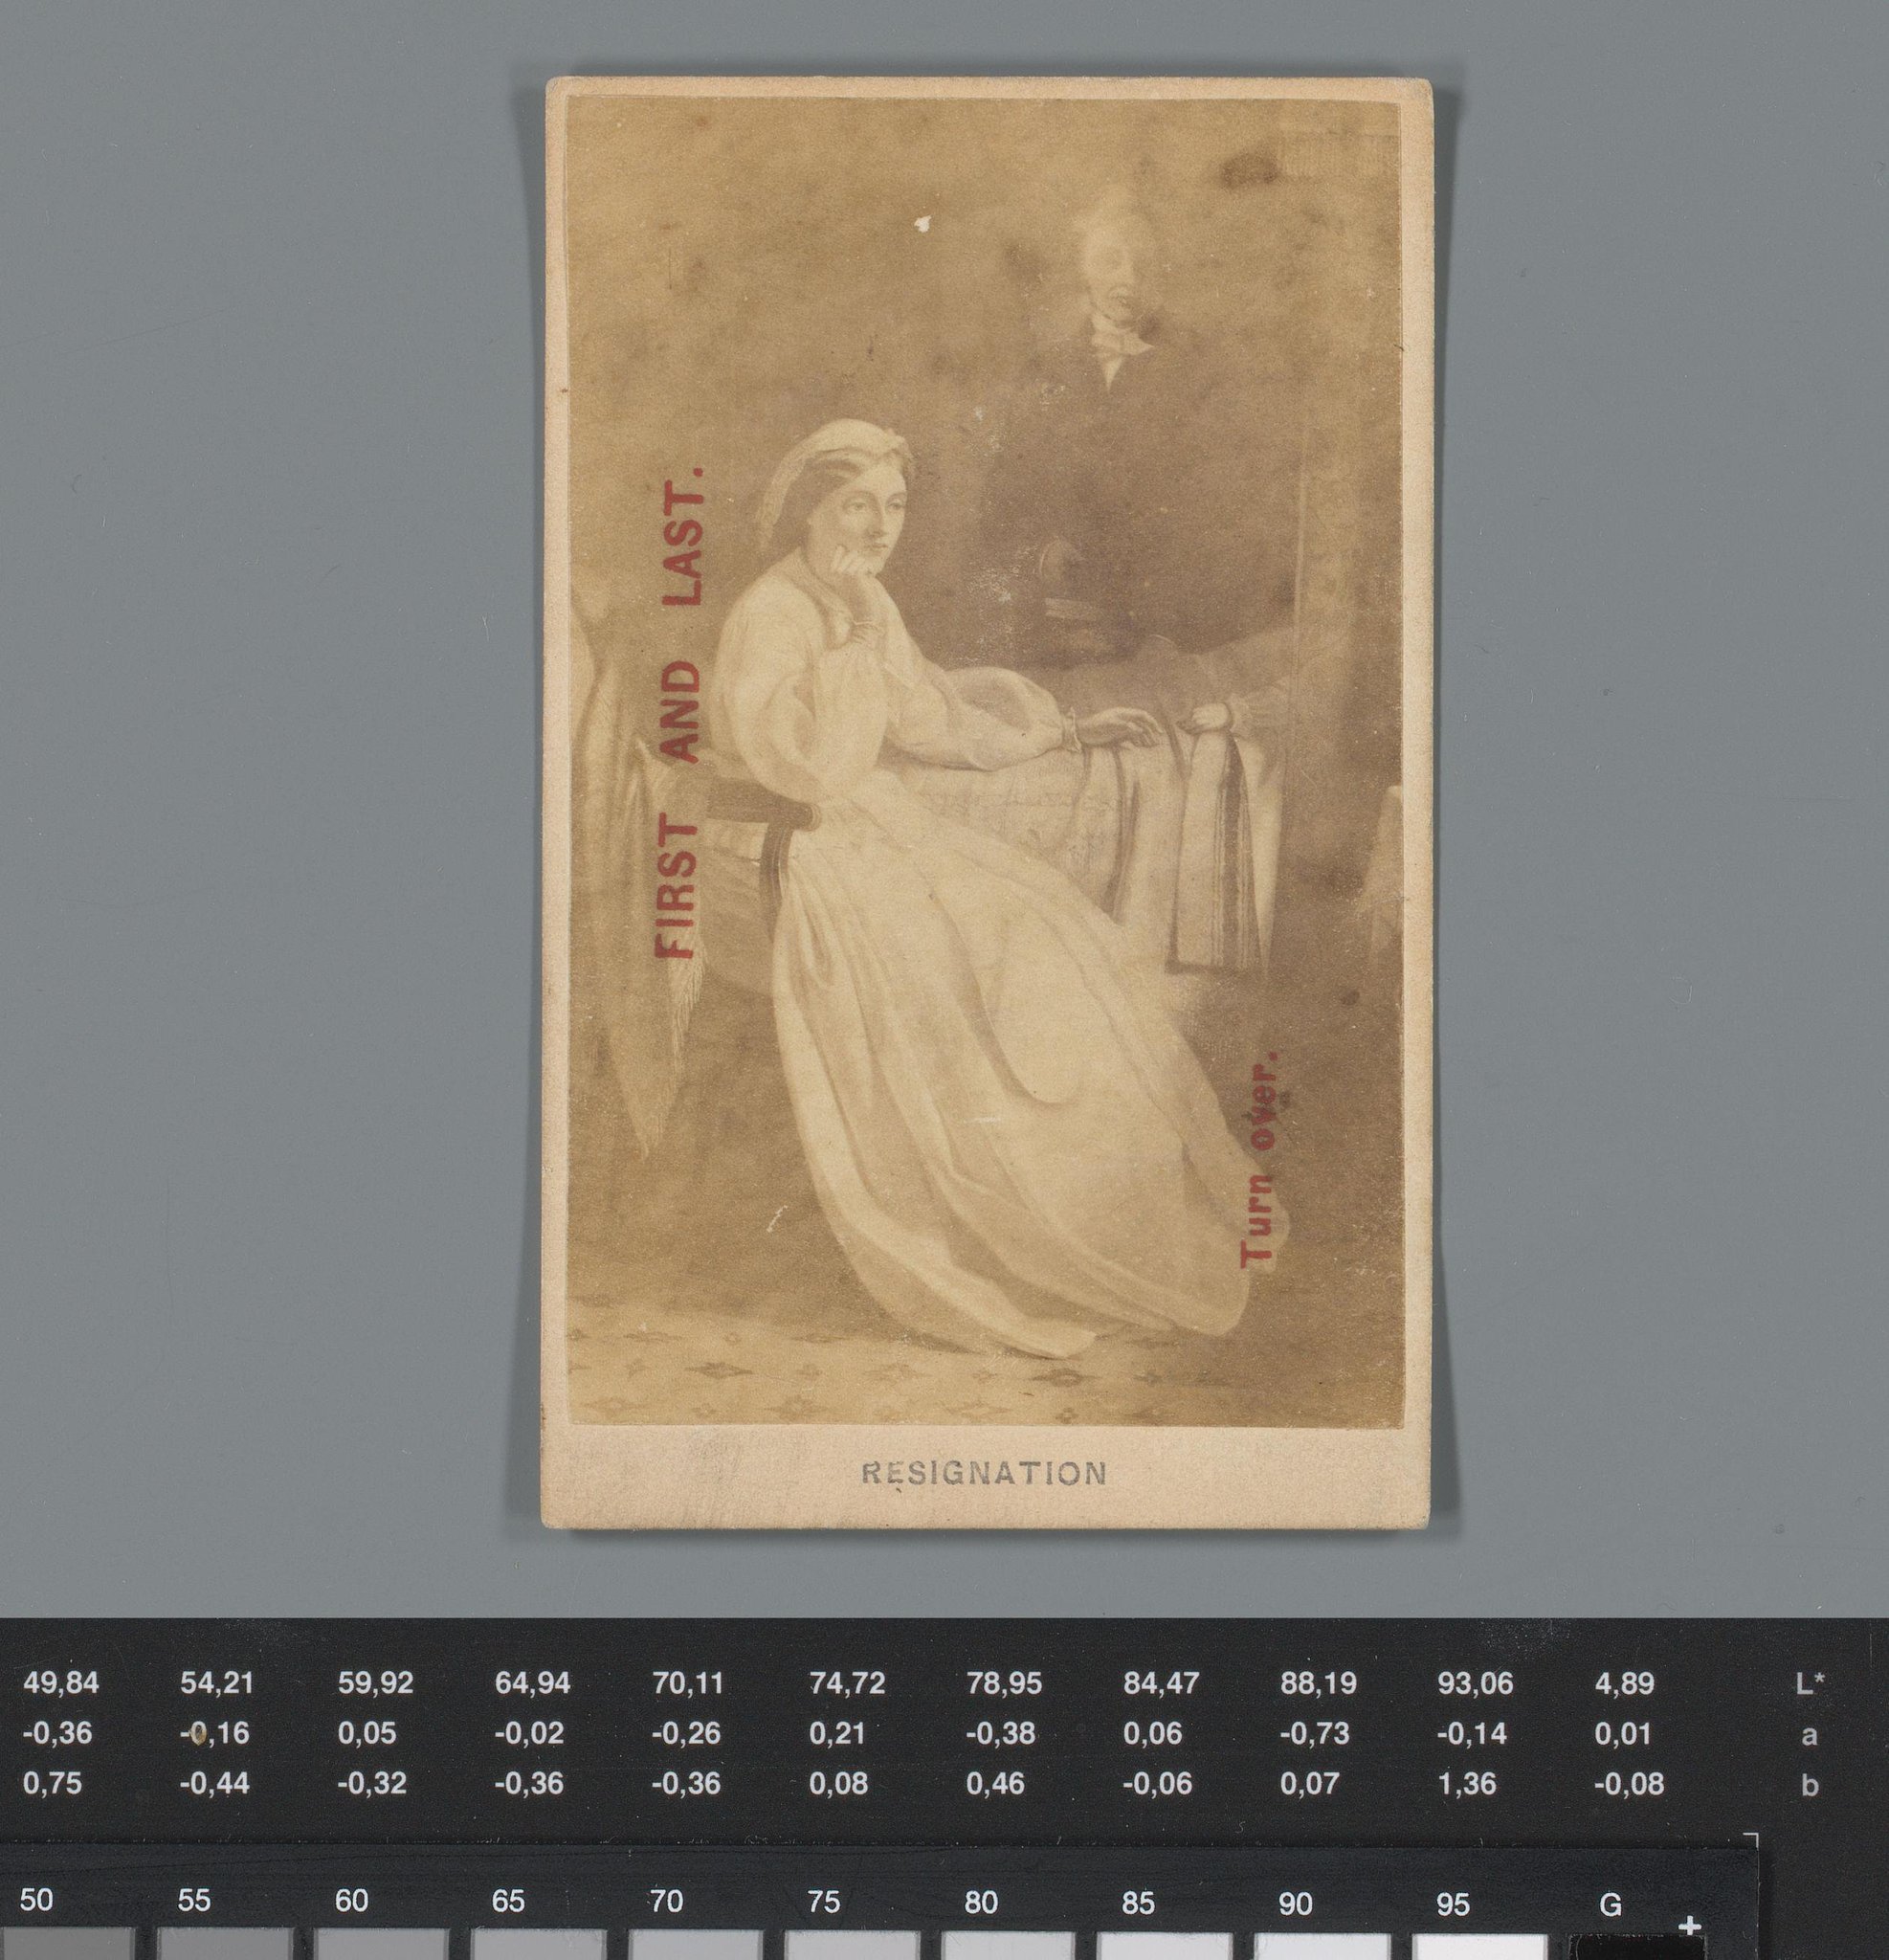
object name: carte de visite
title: Reclame voor goederen van S.F. Lothrop & Co. te Boston met reproductie van een prent van vrouw in een stoel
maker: Anonymous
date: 1850-1915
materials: cardboard, photographic support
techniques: albumen print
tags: armchair, seat, adult woman, advertising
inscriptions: inscription: ‘S. F. LOTHROP & CO. (...) DRY GOODS, / (...) BOSTON. / Goods from New York Auctions daily. / We are bound not to be undersold.’